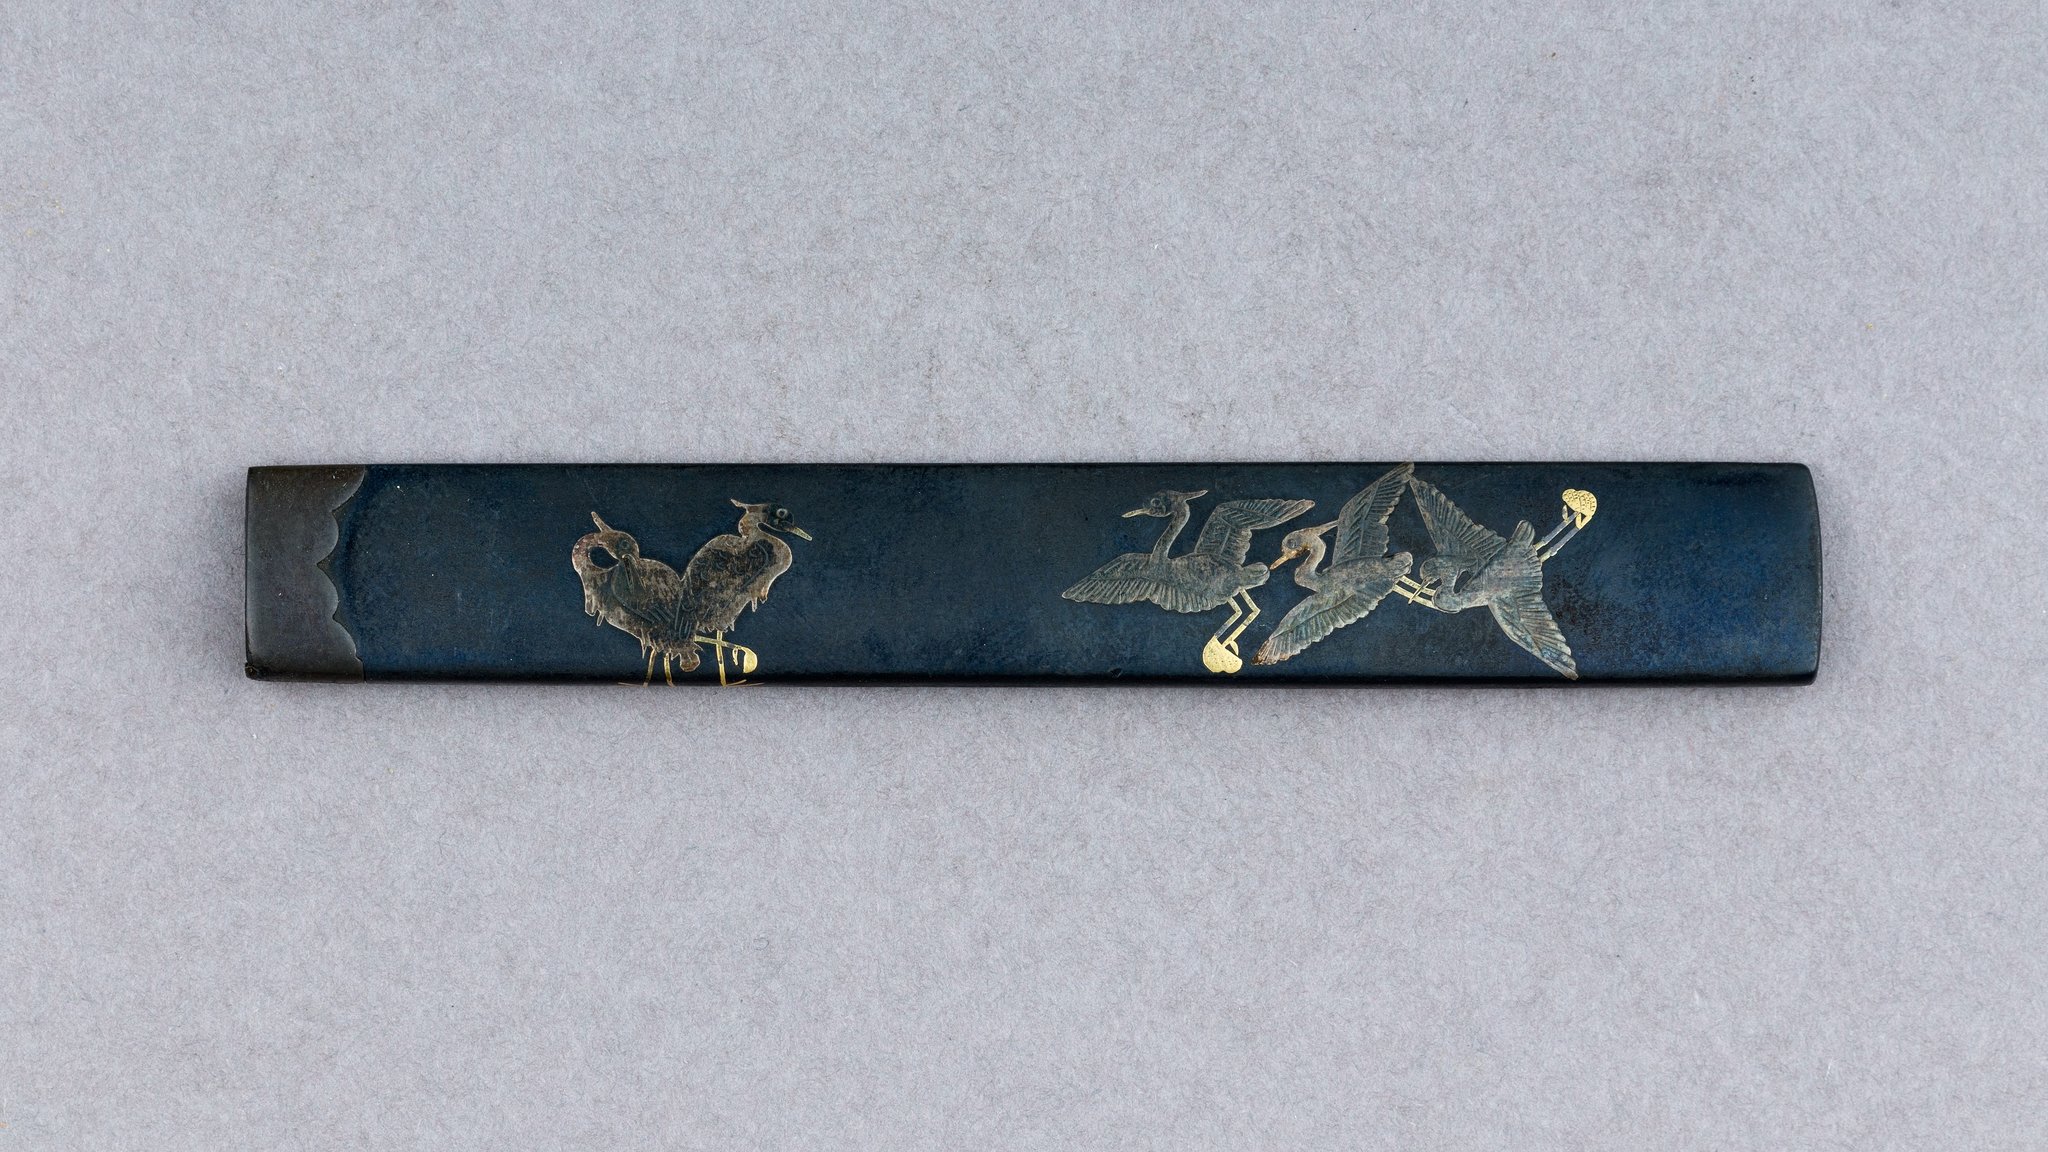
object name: knife handle kozuka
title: Knife Handle (Kozuka)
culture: japanese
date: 1615-1868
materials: gold alloy, silver alloy, gold, silver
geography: japan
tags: birds